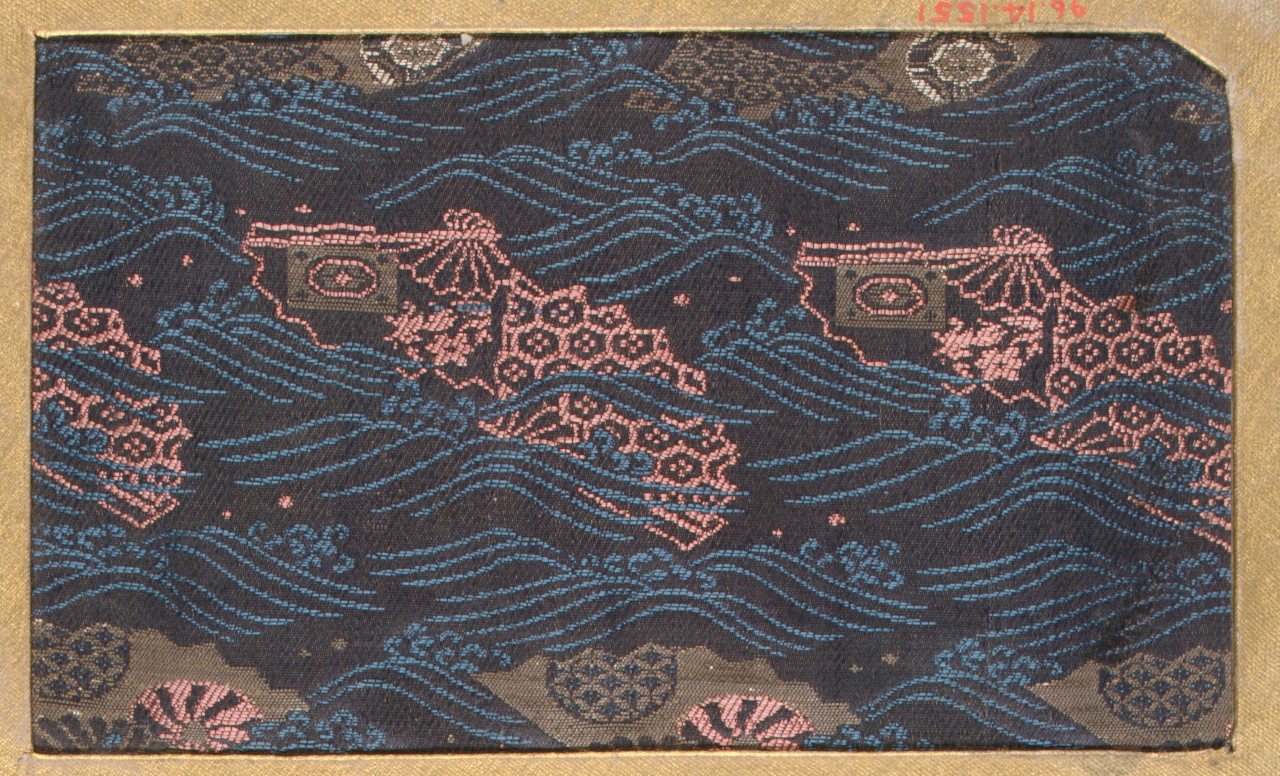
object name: piece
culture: japanese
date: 1701-1900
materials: silk